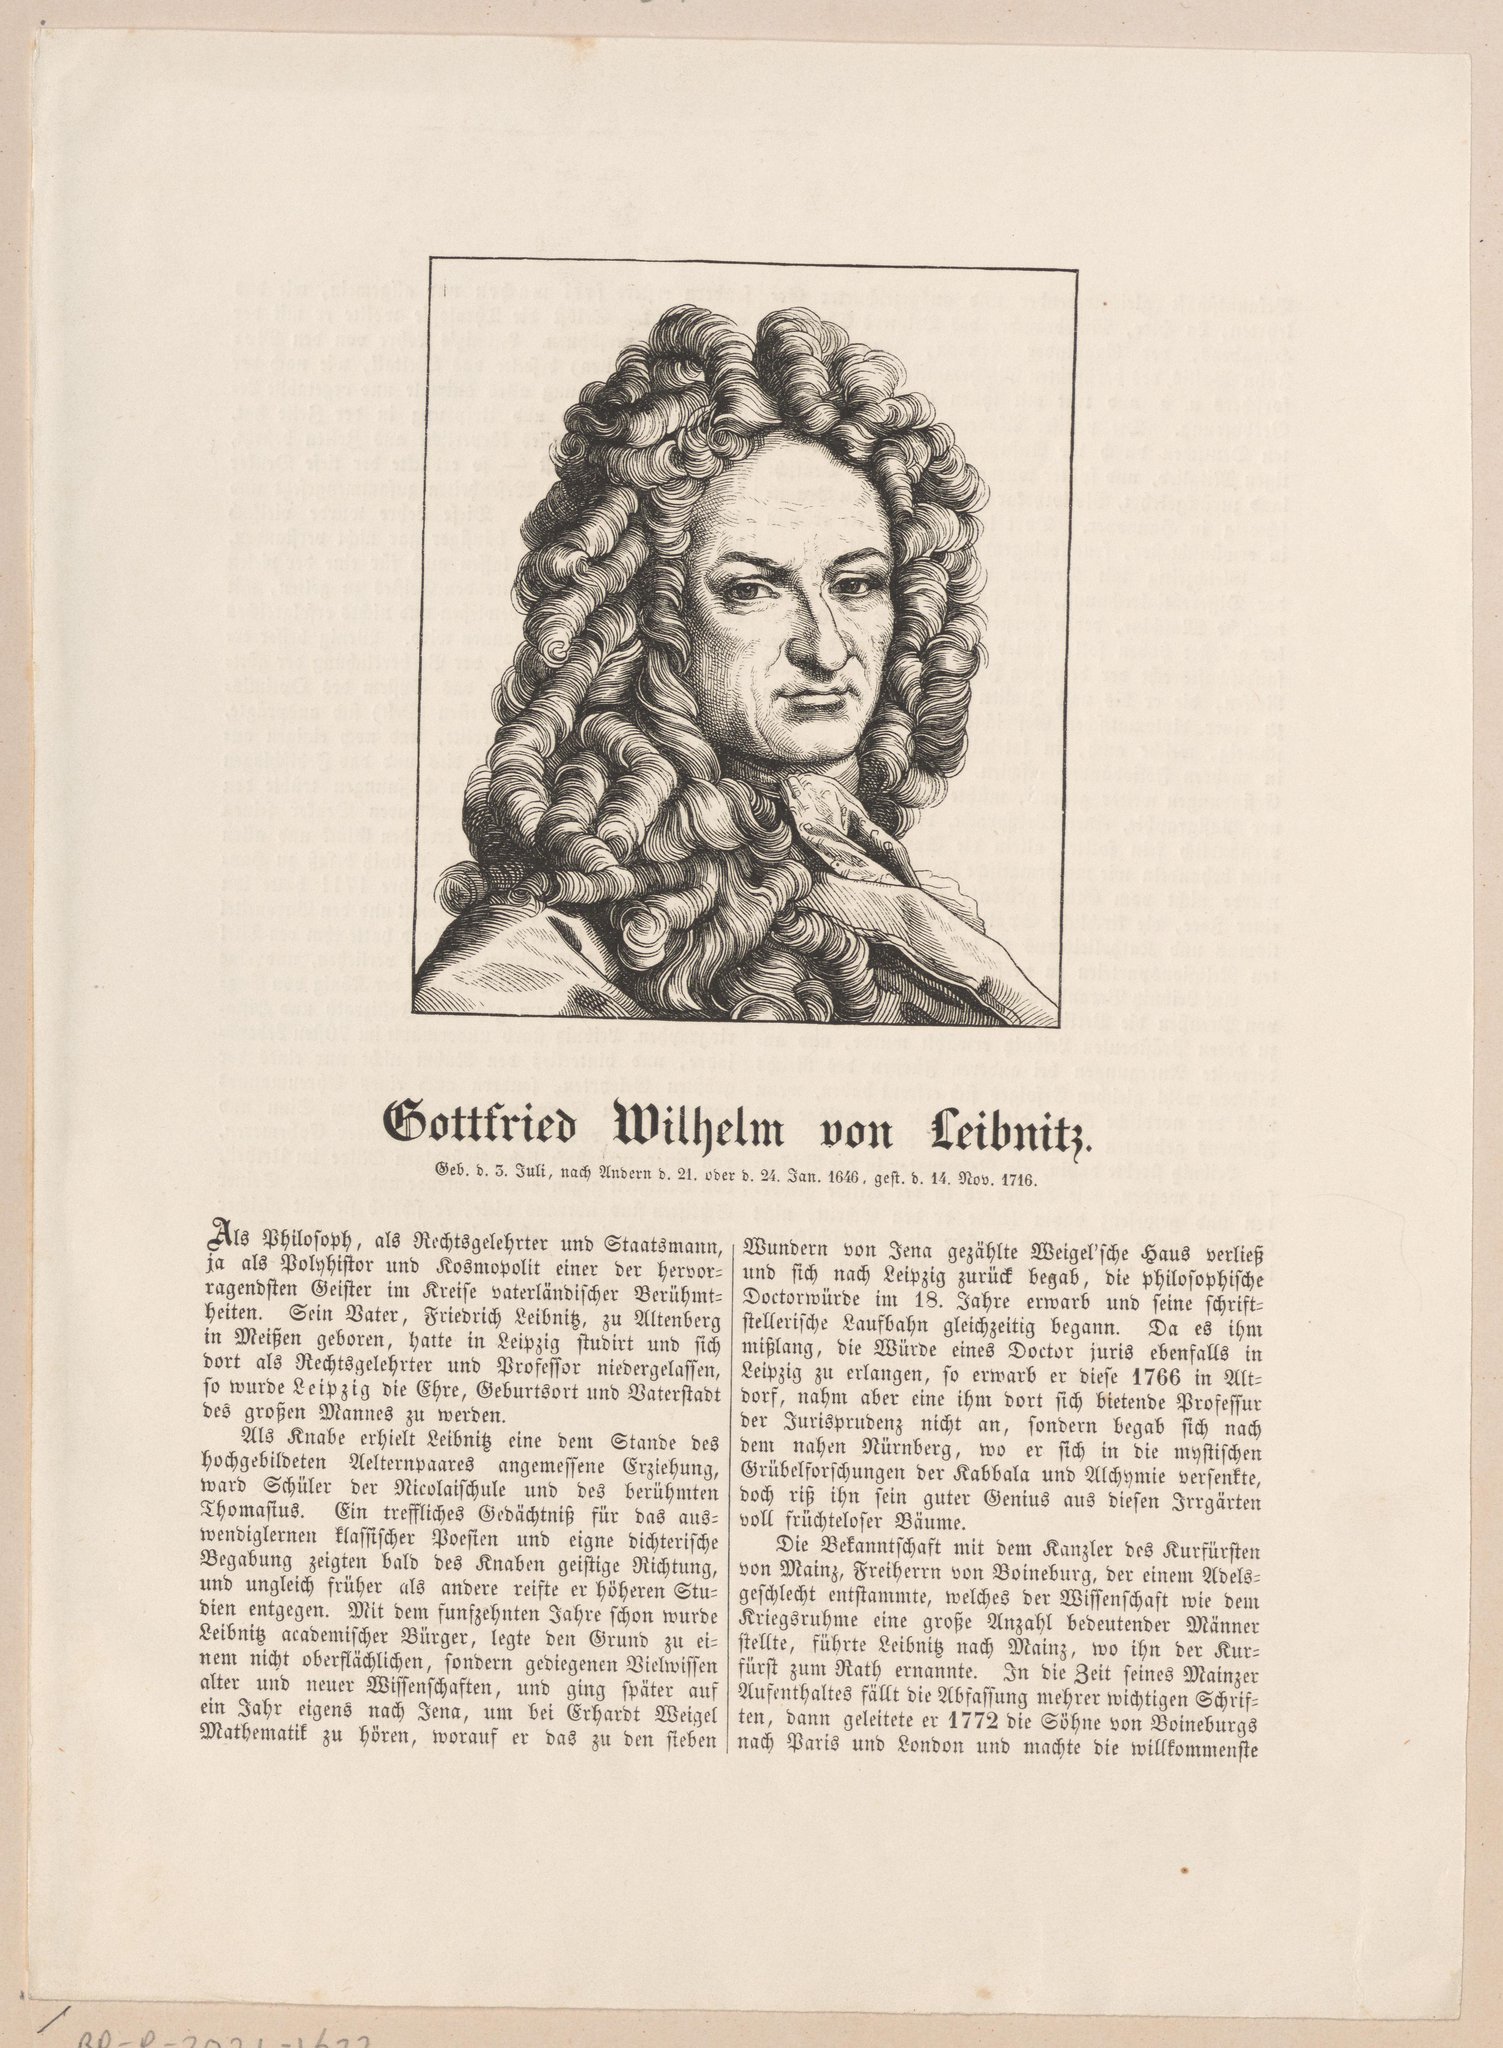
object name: print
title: Portret van Gottfried Wilhelm Leibniz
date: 1854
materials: paper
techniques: letterpress printing, engraving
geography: leipzig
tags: historical persons, scholar, philosopher (+ portrait of scholar, scientist)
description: Bladzijde uit: Bechstein, Ludwig. Zweihundert deutsche Männer in Bildnissen und Lebensbeschreibungen. Leipzig: Georg Wigand, 1854. Prent ook gebruikt in 'Dreihundert Bildnisse und Lebensabrisse berühmter deutscher Männer', waarbij op de titelpagina vermeld staat dat de prenten zijn gemaakt door Hugo Bürkner.